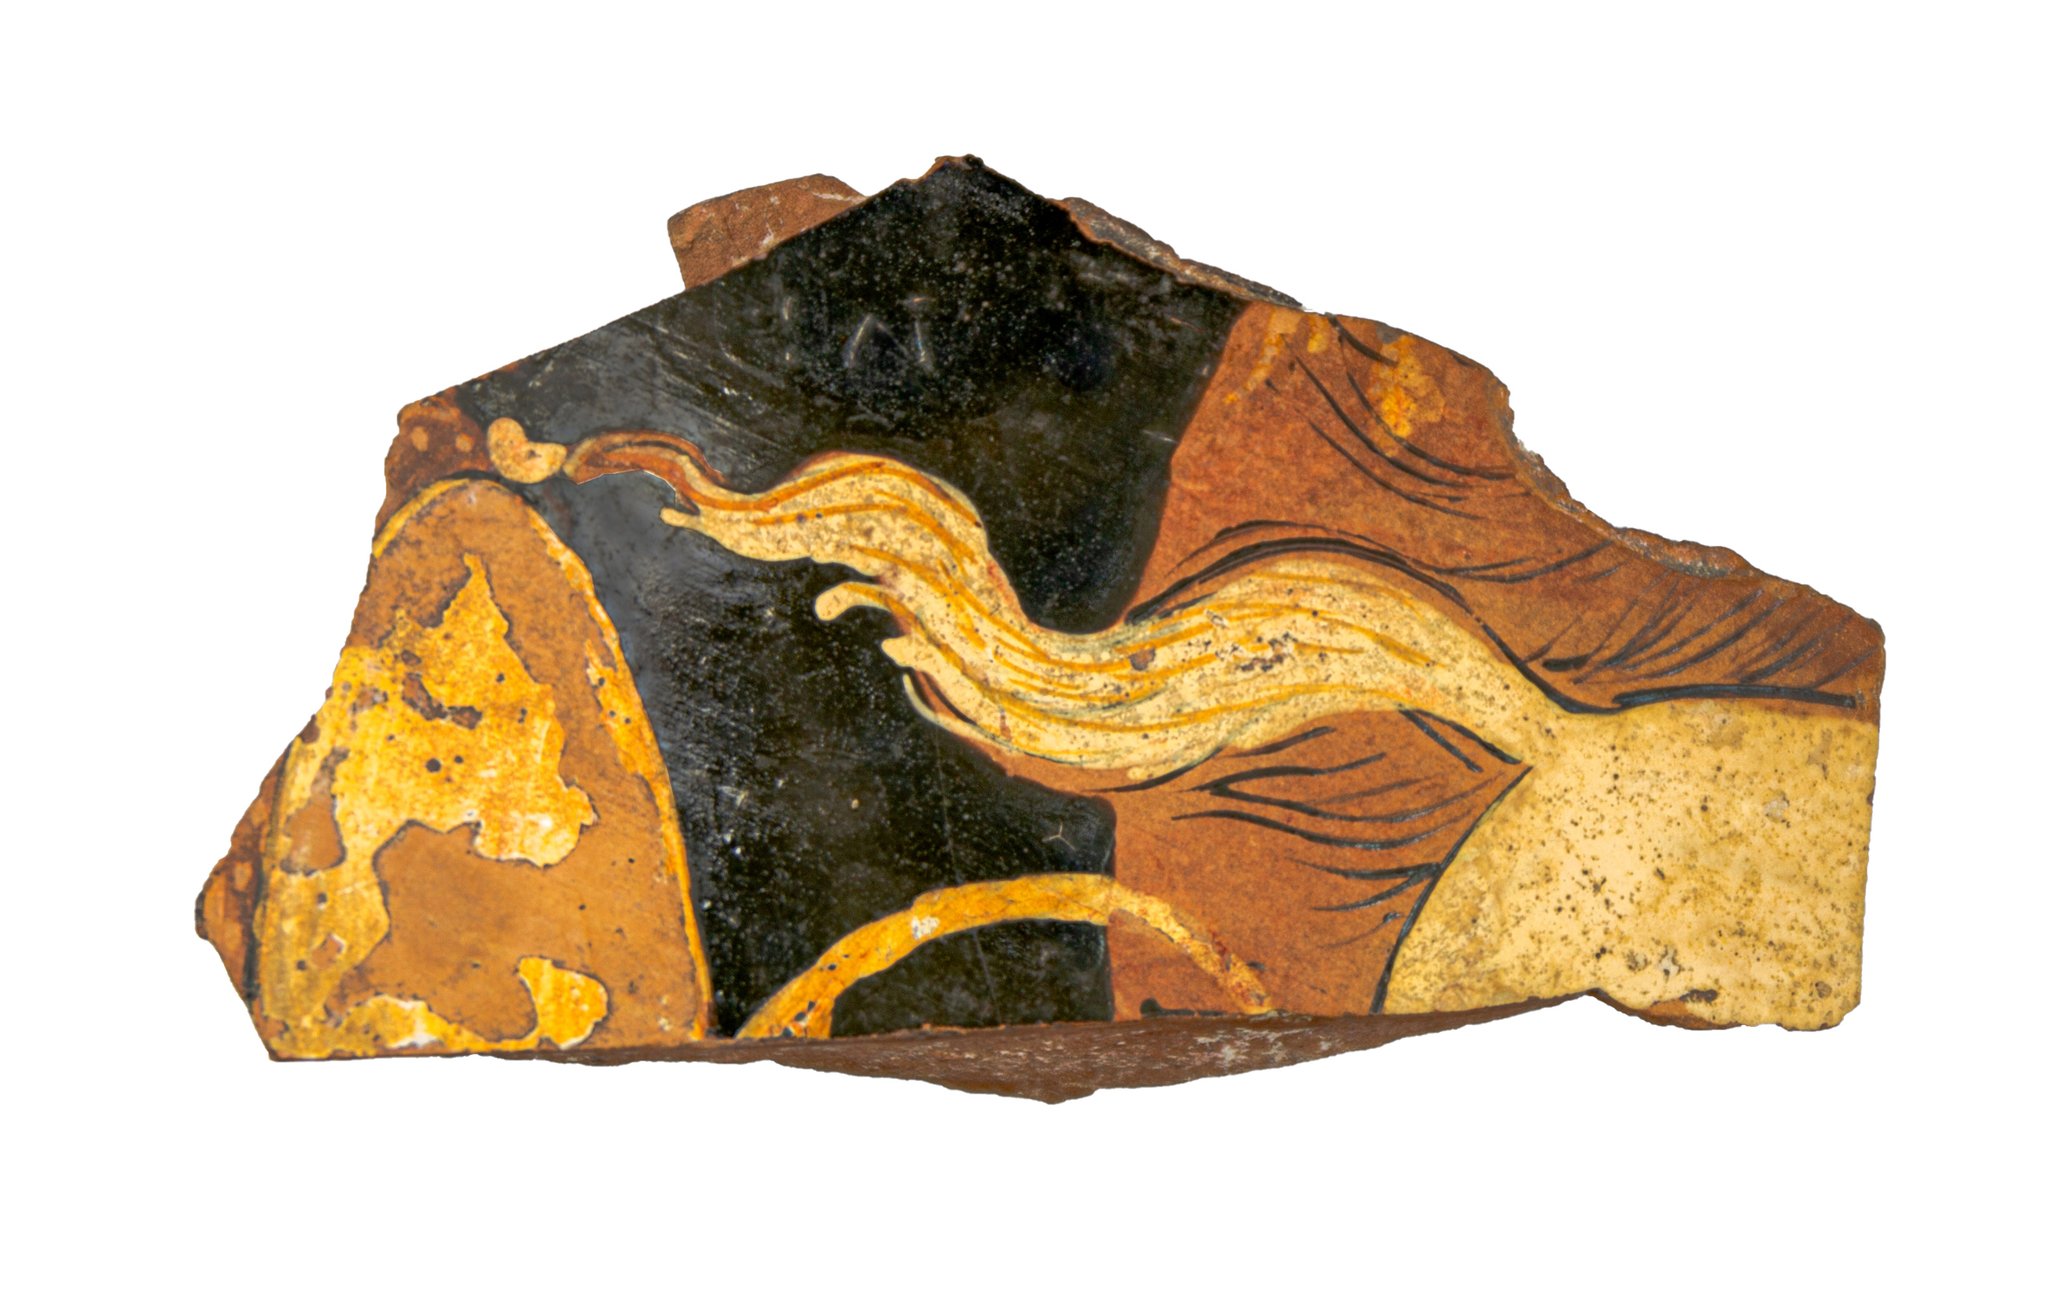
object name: volute krater fragment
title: Volute-krater fragment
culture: greek, south italian, apulian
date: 350-300 BCE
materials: terracotta